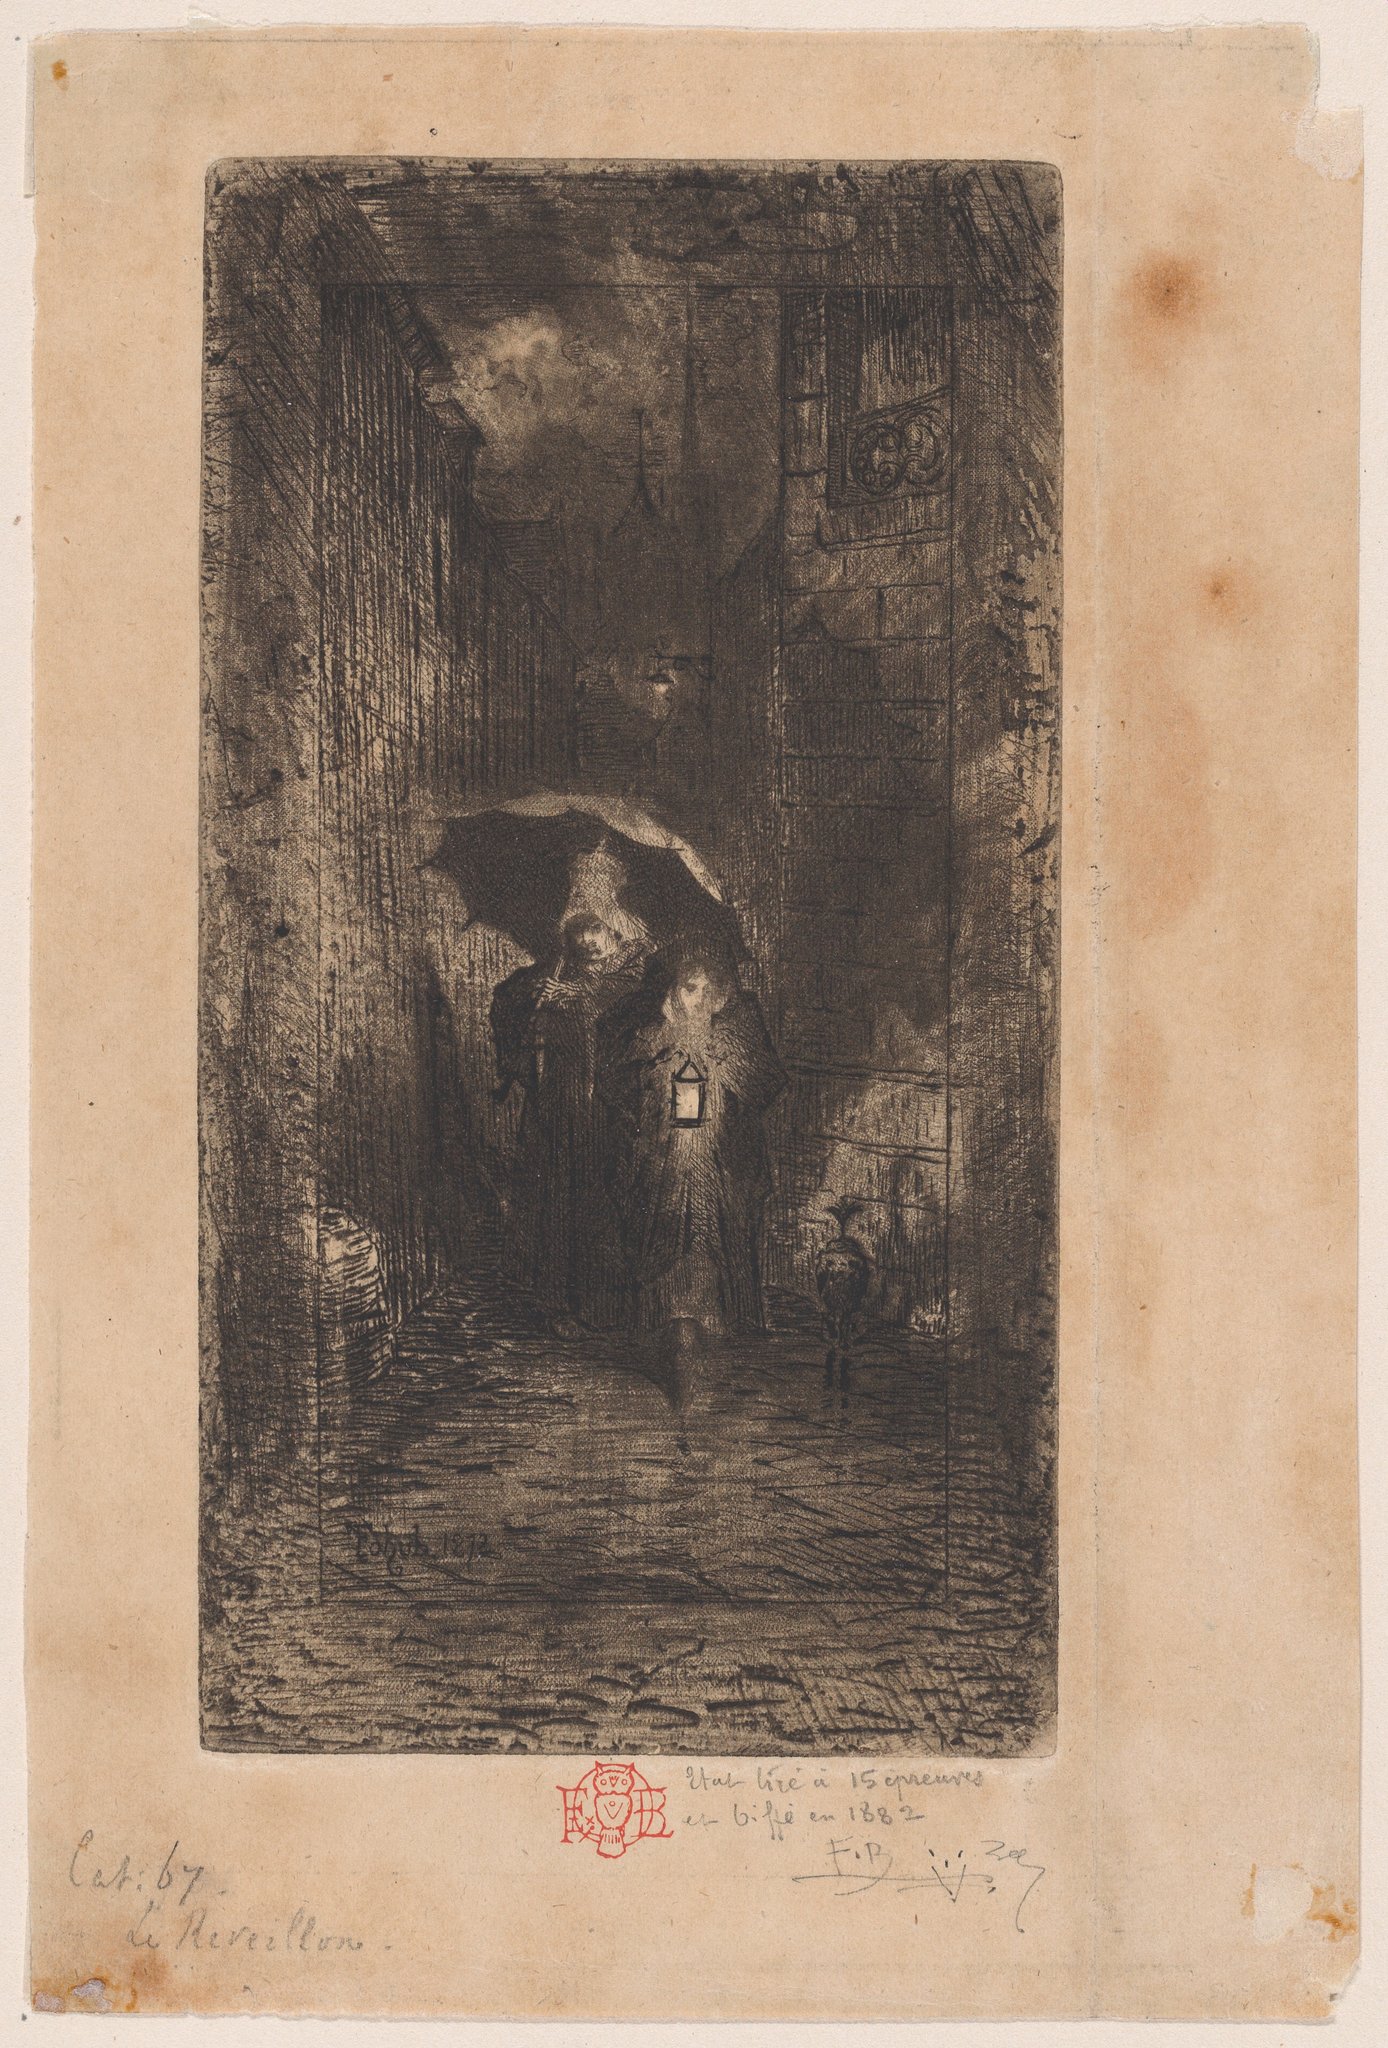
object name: print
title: Midnight Revel (Le Réveillon)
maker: félix-hilaire buhot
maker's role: artist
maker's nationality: french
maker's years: 1847-1898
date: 1851-1900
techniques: aquatint, burnishing, drypoint, etching, roulette